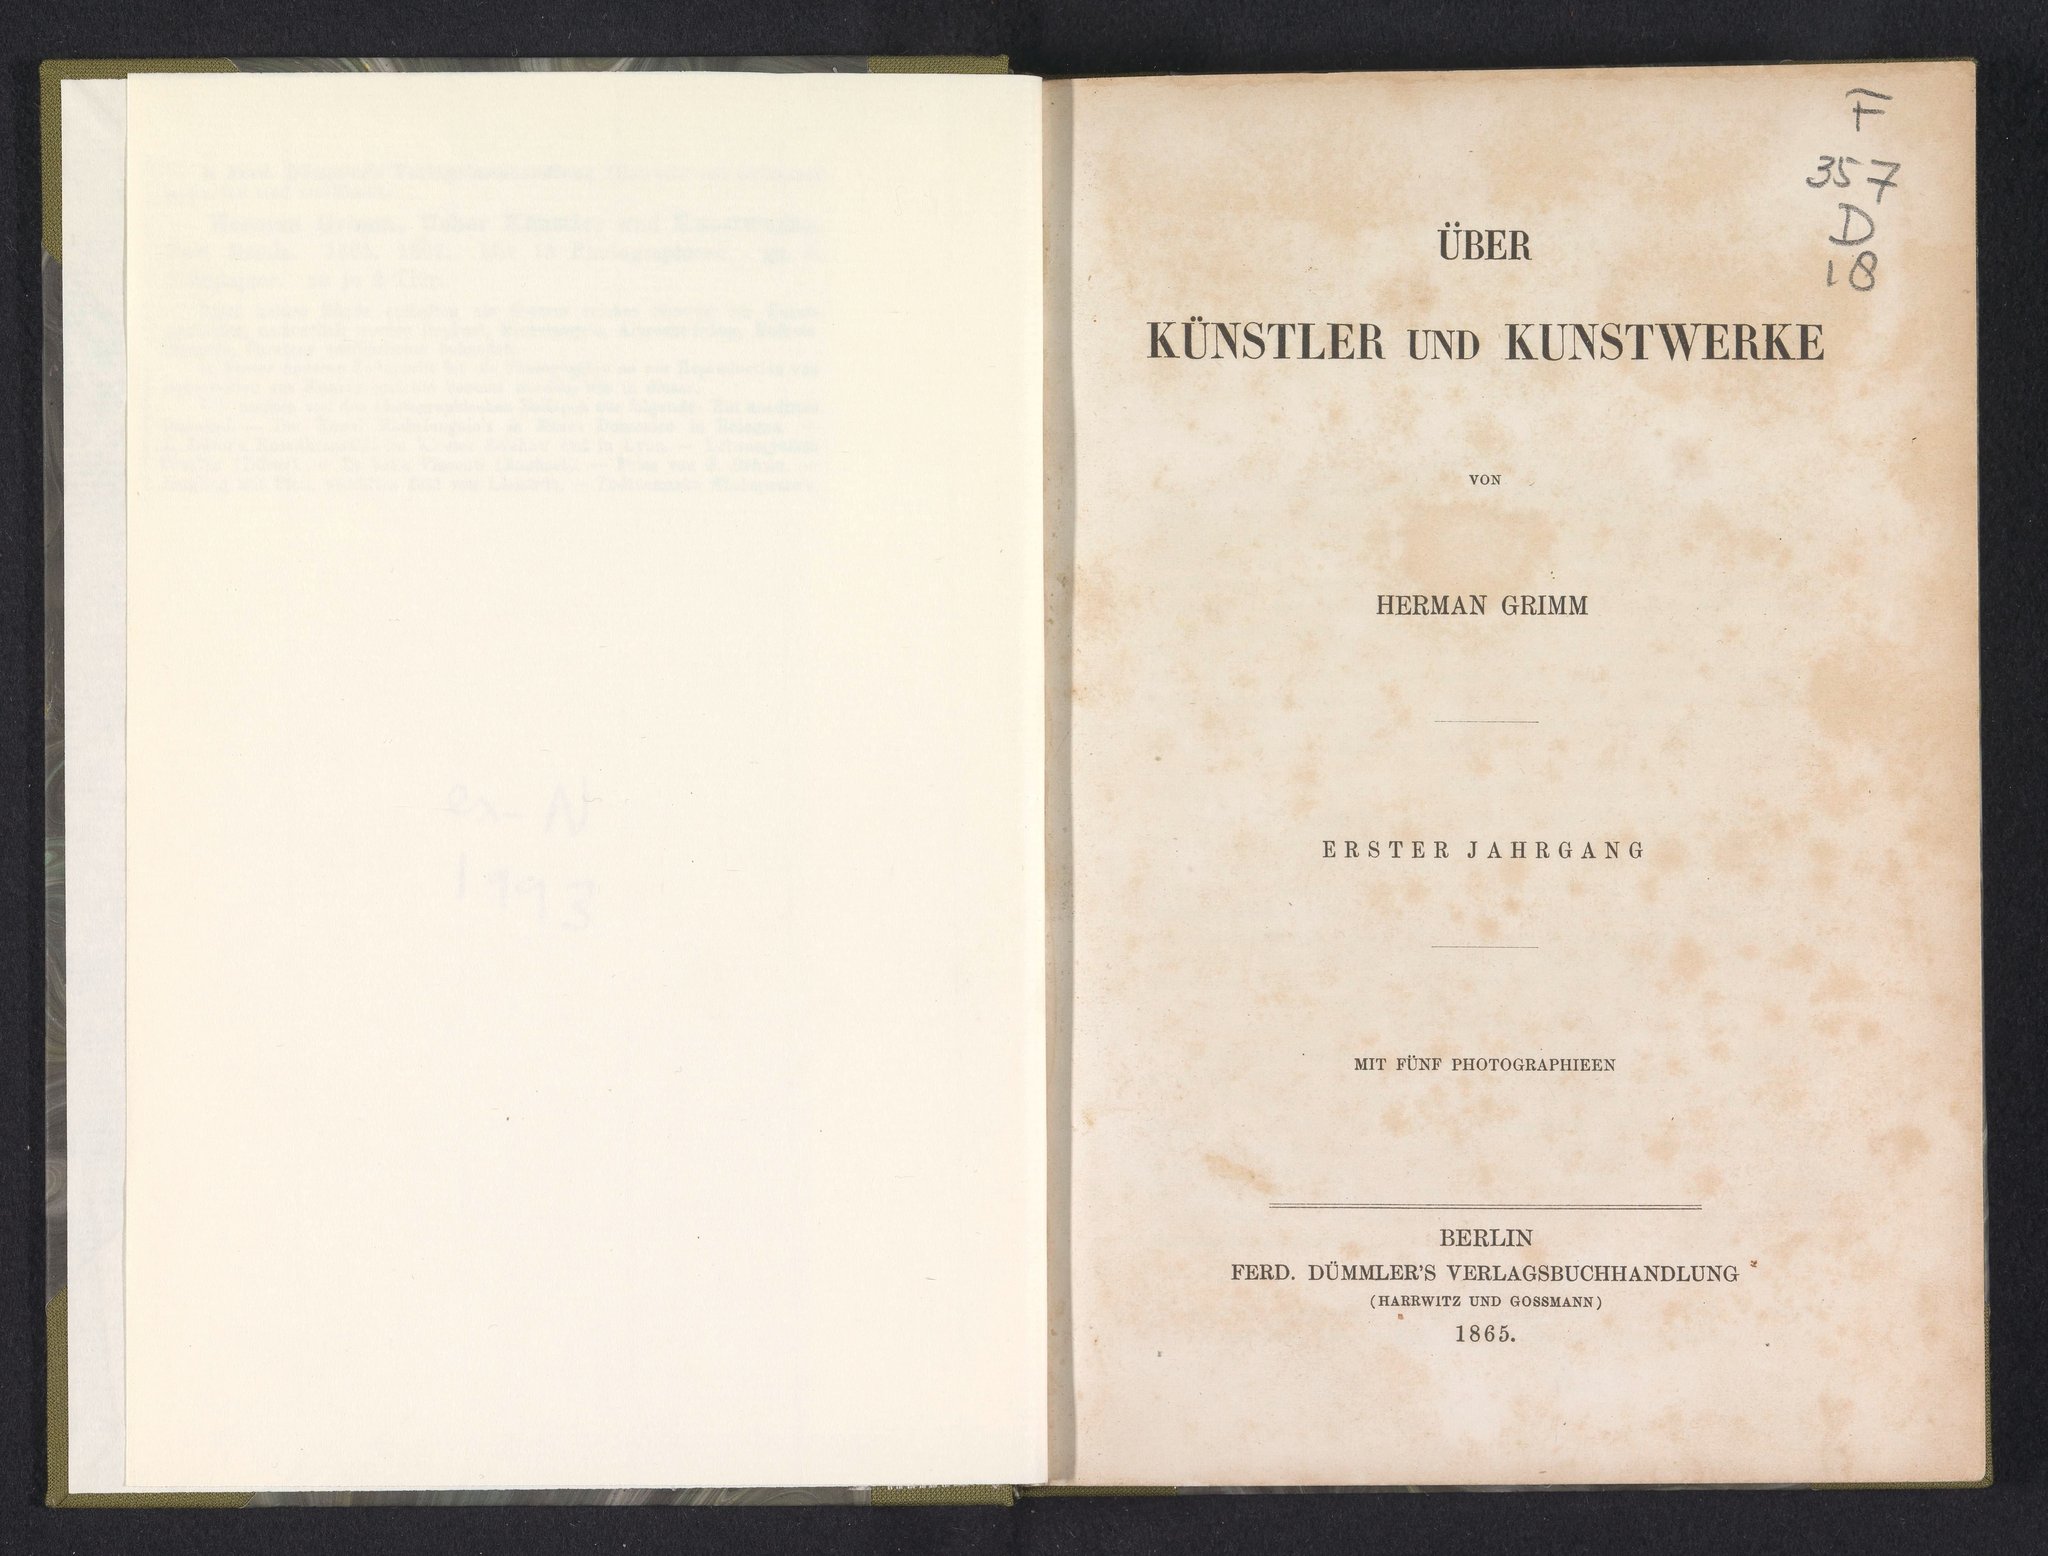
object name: book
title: Über Künstler und Kunstwerke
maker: herman grimm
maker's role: kunsthistoricus, publicist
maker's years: 1828-1901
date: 1865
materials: cardboard, linen, paper, photographic support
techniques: albumen print, marbled paper, printing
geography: berlin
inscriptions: inscription: ‘In Ferd. Dümmler's (...) Todtenmaske Shakespeare's.’